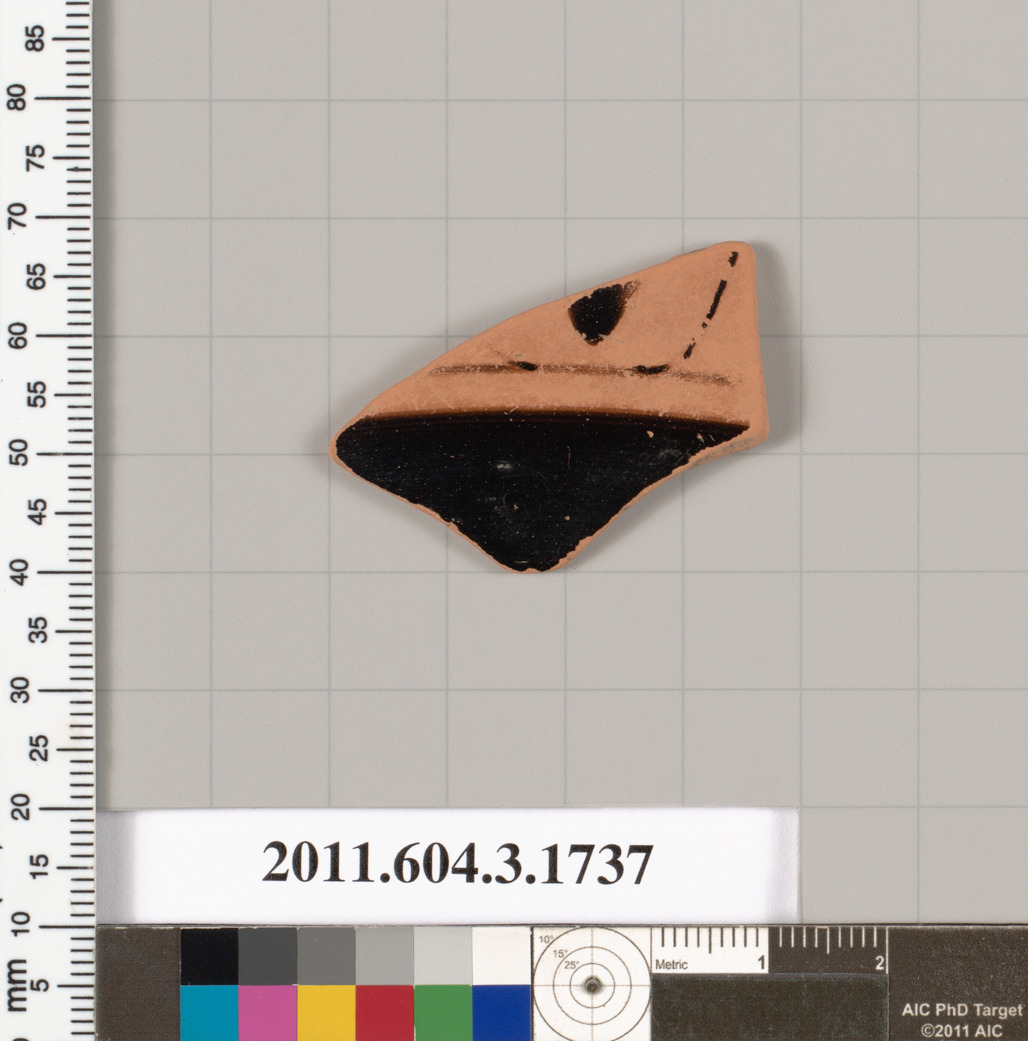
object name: kylix fragment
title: Terracotta fragment of a kylix: Lip cup (drinking cup)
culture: greek, attic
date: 550-526 BCE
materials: terracotta